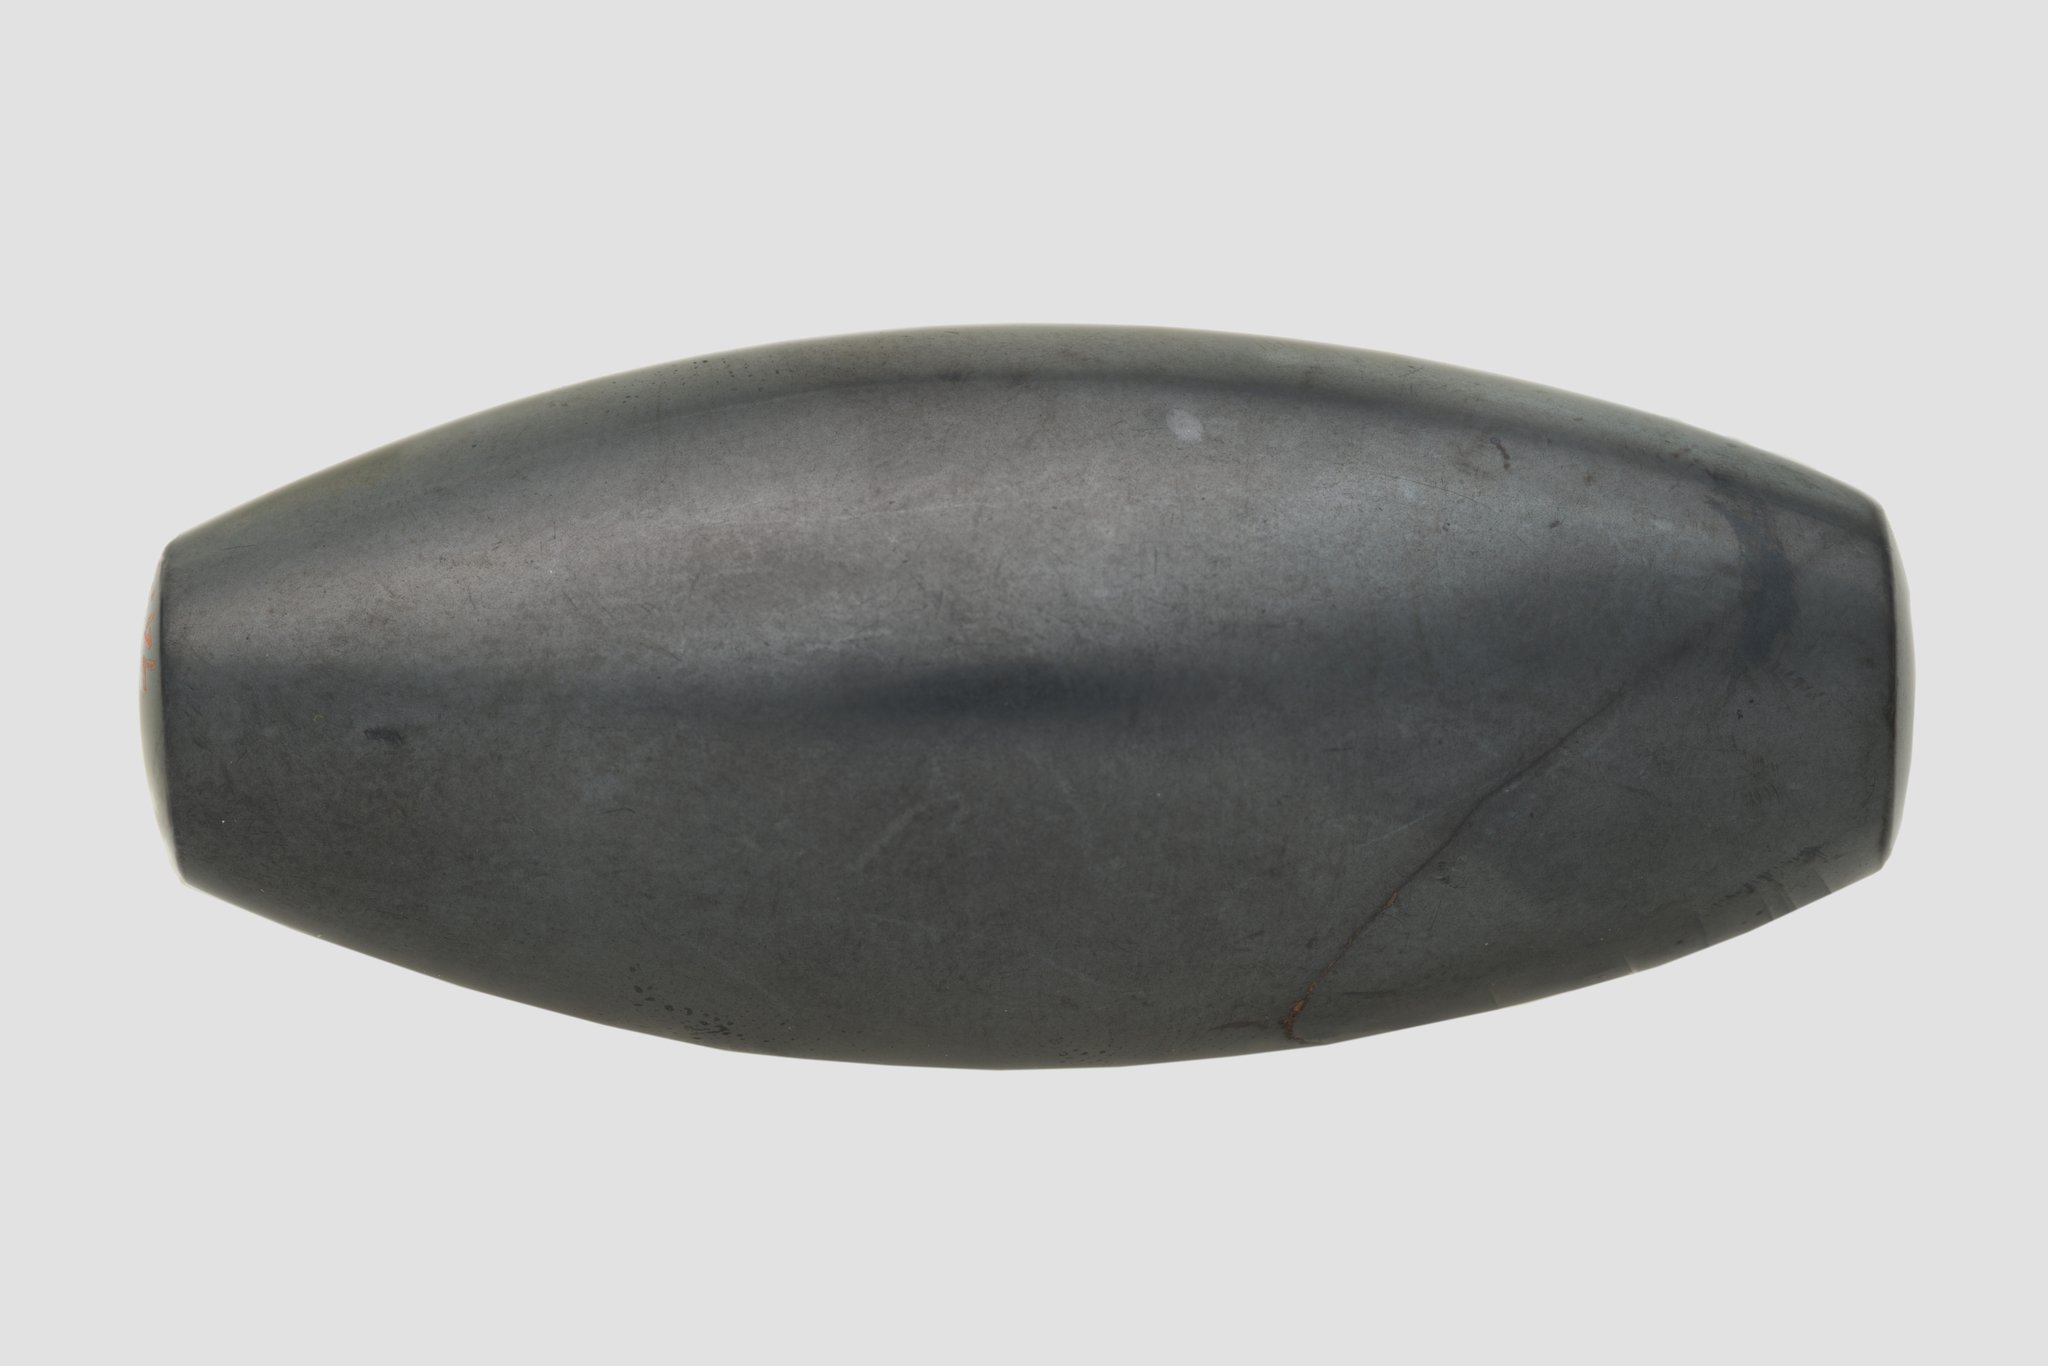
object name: weight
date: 3000-1 BCE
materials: mineral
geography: cyprus or western asia